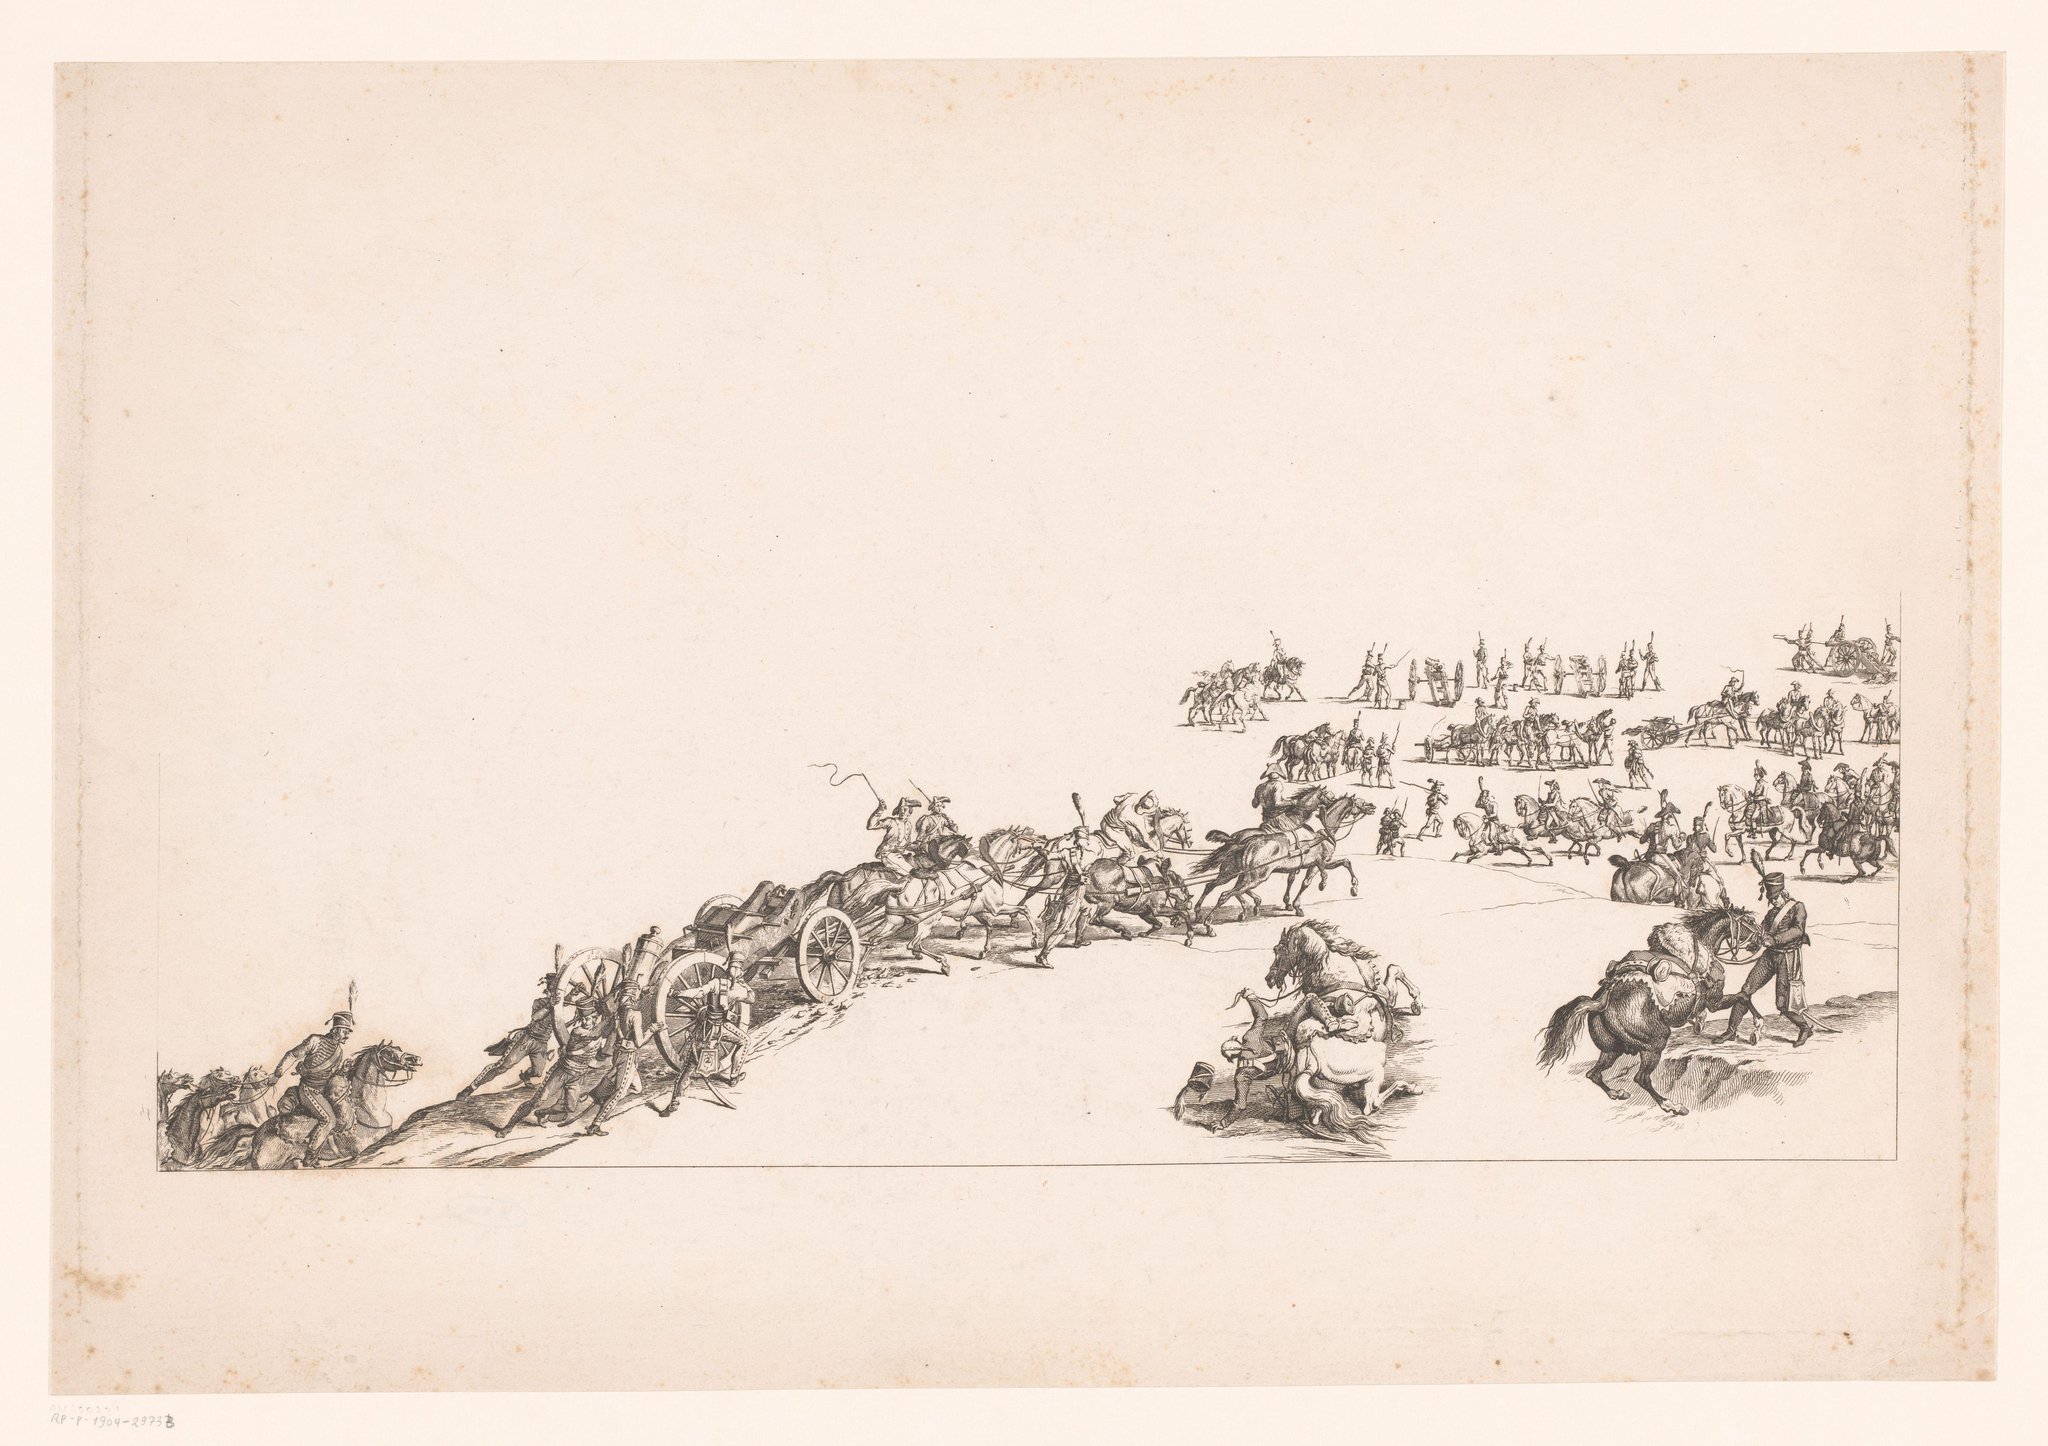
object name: print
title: Cavalerie in actie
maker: jean duplessis-bertaux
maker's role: print maker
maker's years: 1750-1818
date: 1760-1818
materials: paper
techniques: etching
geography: france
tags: battle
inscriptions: collector's mark: Lugt 2228